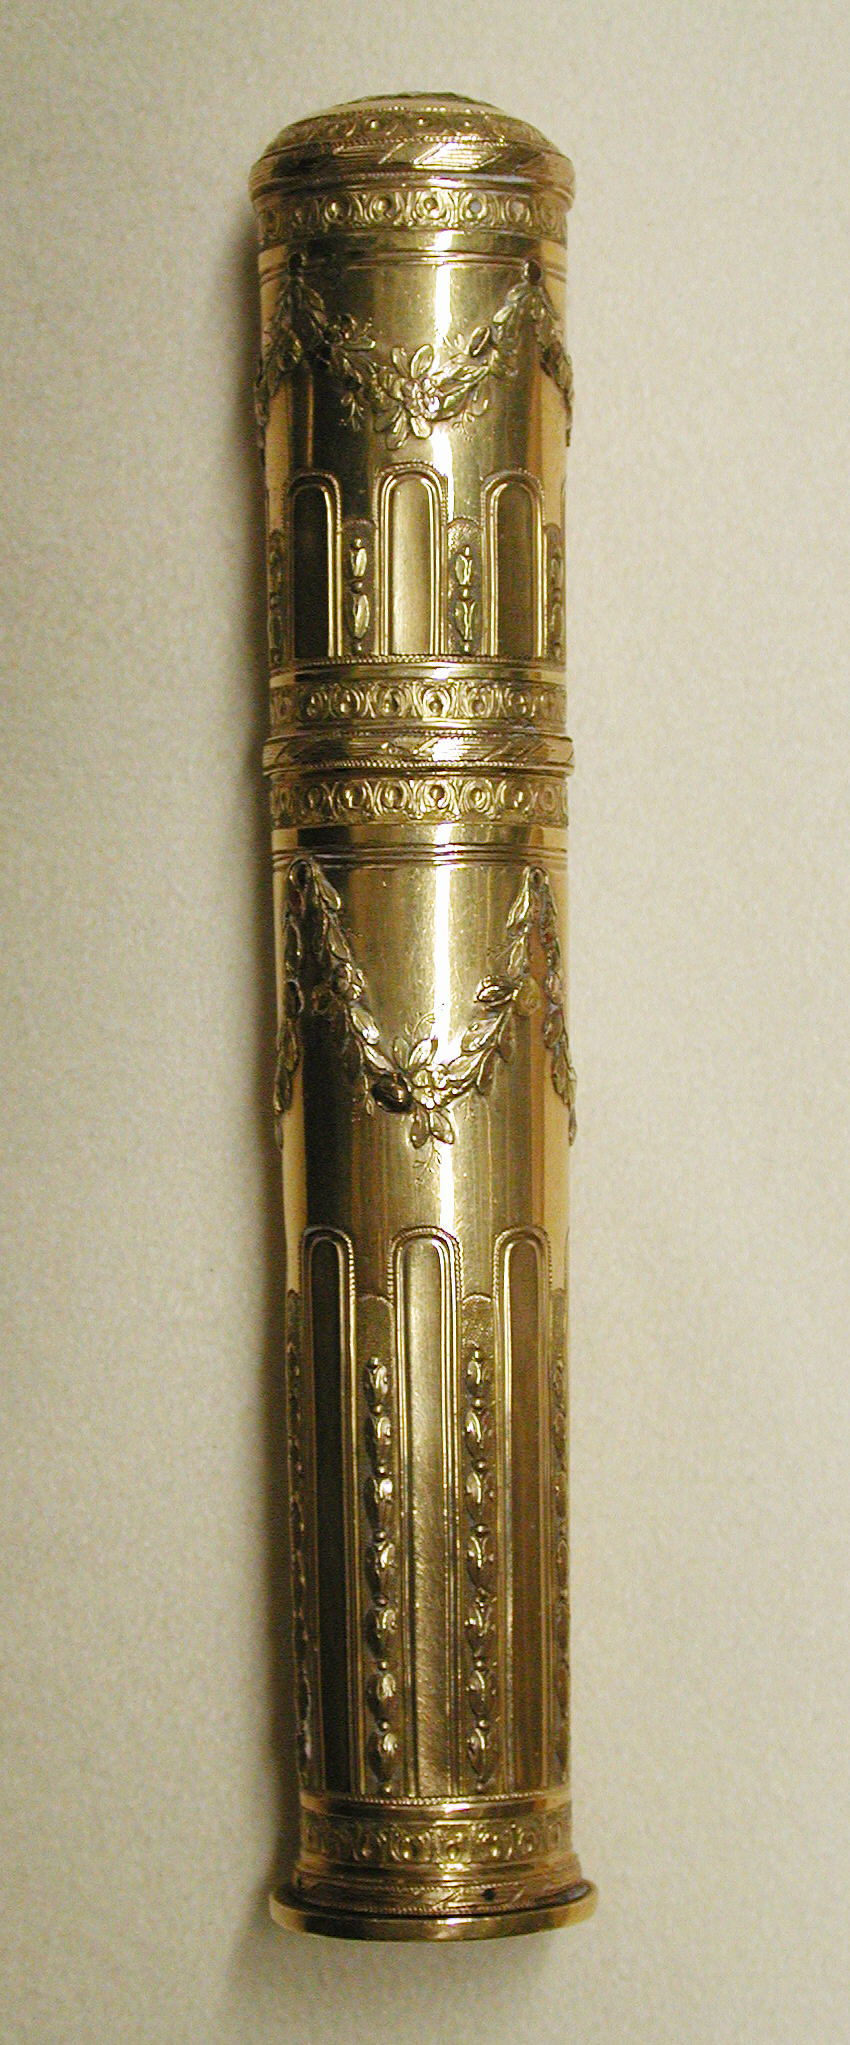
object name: étui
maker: mathieu coiny fils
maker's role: artist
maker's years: 1723-1823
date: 1771-1772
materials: gold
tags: flowers